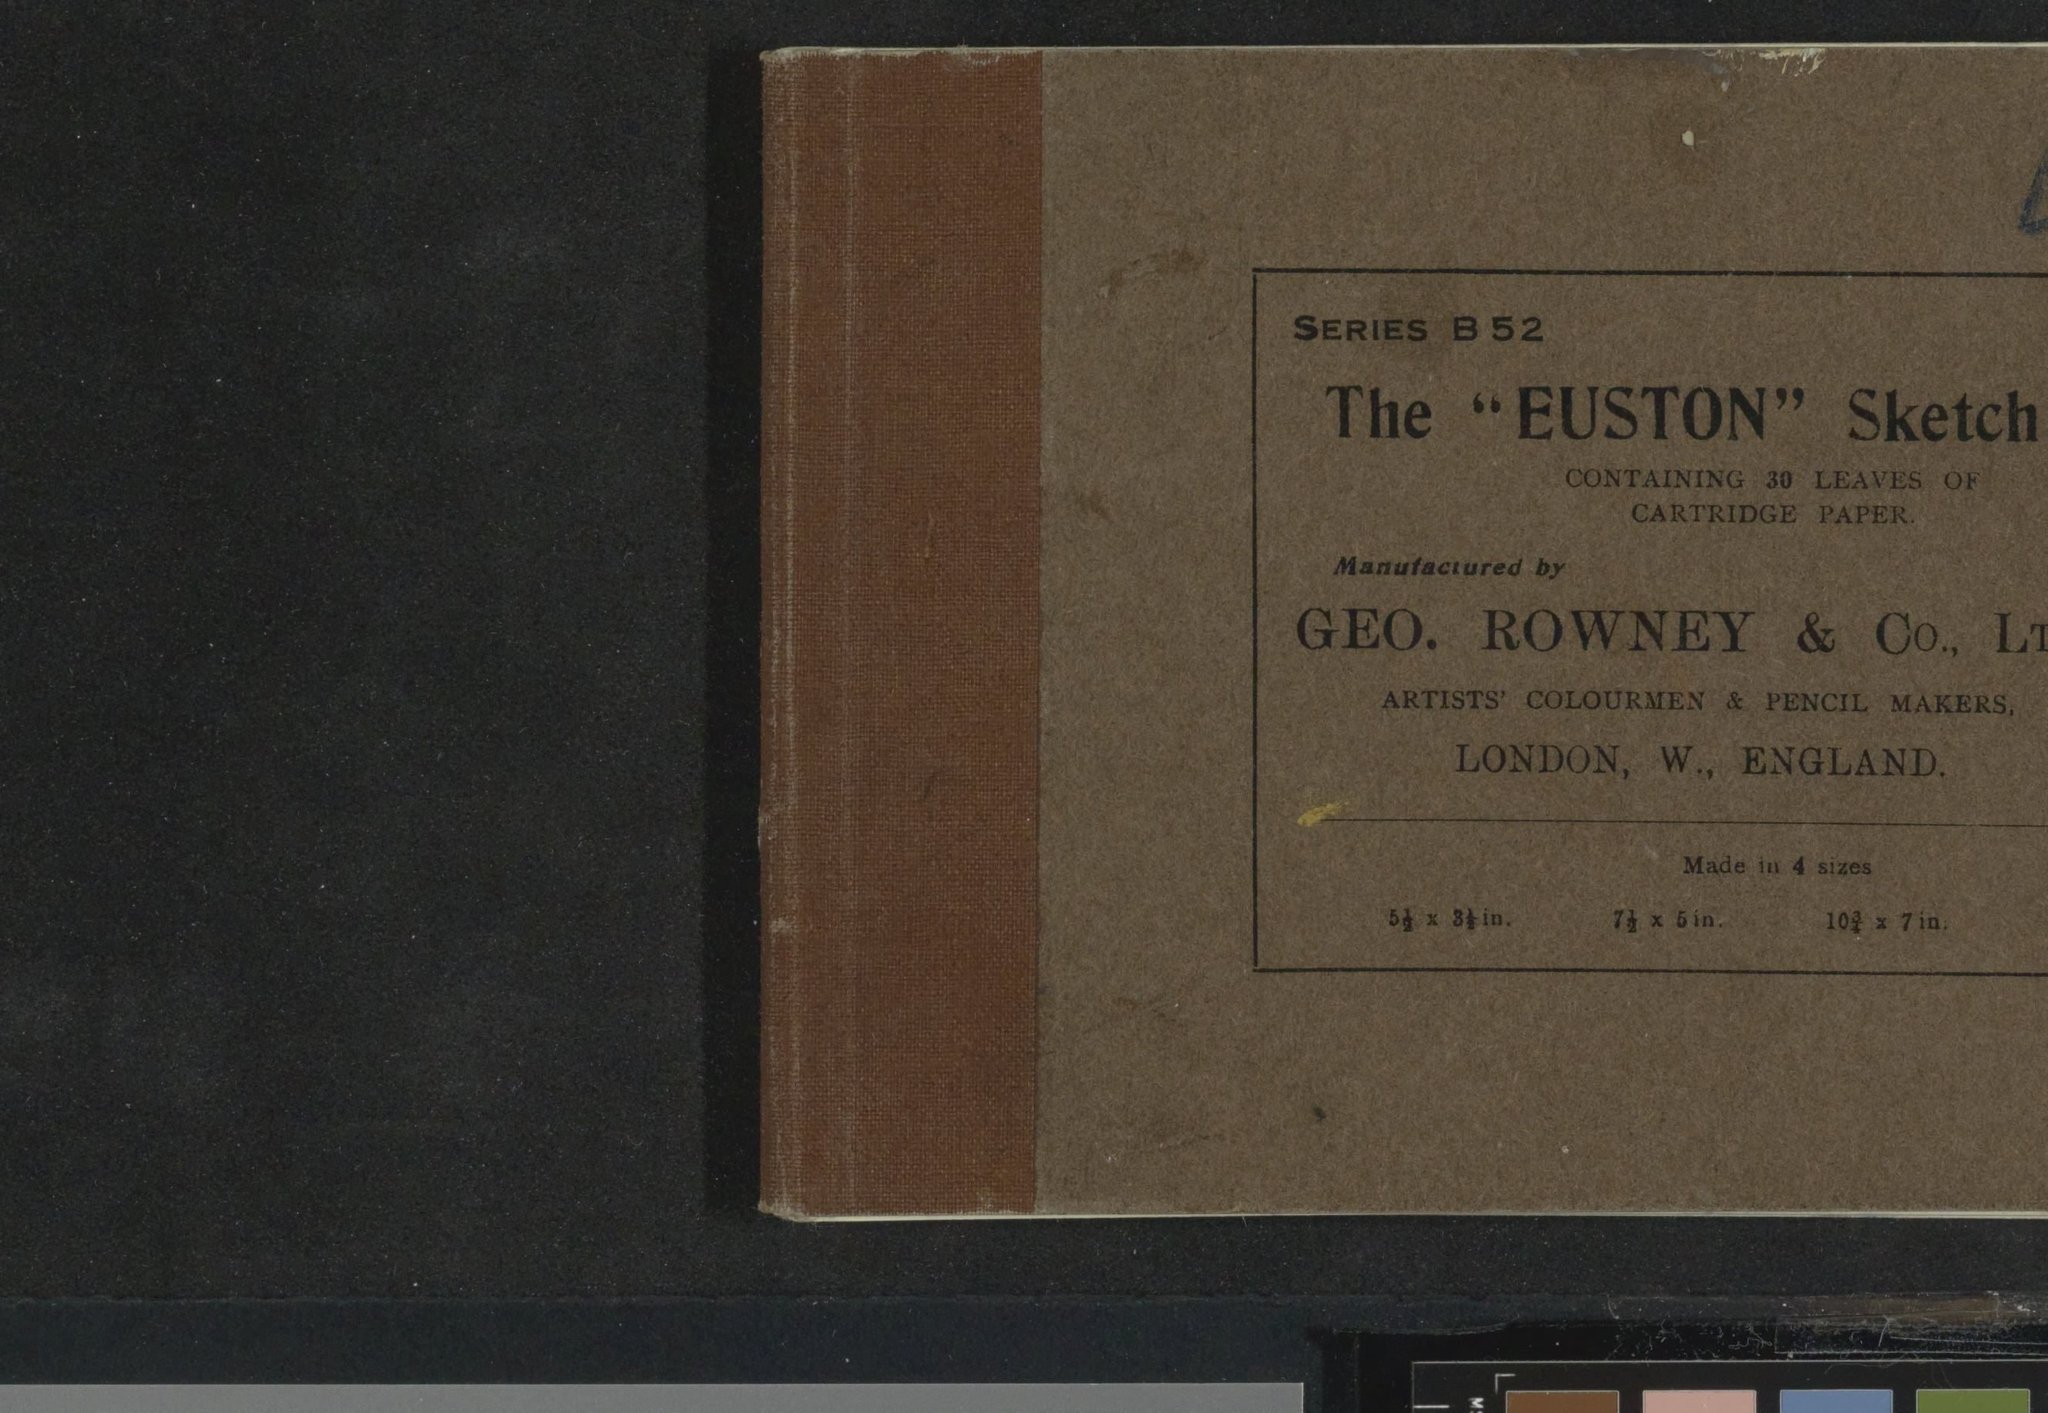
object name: sketchbook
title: Schetsboek LXI met 20 bladen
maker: isaac israels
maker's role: draughtsman, painter, print maker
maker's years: 1865-1934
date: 1875-1934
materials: cardboard, linen, paper, pencil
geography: the hague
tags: adult man (+ standing), cabaret-artiste, picture, painting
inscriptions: factory mark: ‘Series B 52 / Size 7 1/2 x 5 in. / The "Euston" Sketch Book / containing 30 leaves of cartridge paper. / Manufactured by / Geo. Rowney & Co., Ltd., / artists' colourmen & pencil makers, / London, W., England. / [...]’, collector's mark: Lugt 2228, retailer's mark: ‘W.M. Stam / Den Haag / 15 Papestraat’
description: Schetsboek nr. LXI bestaande uit 20 bladen met artiesten en studies van een schilderij op een ezel.